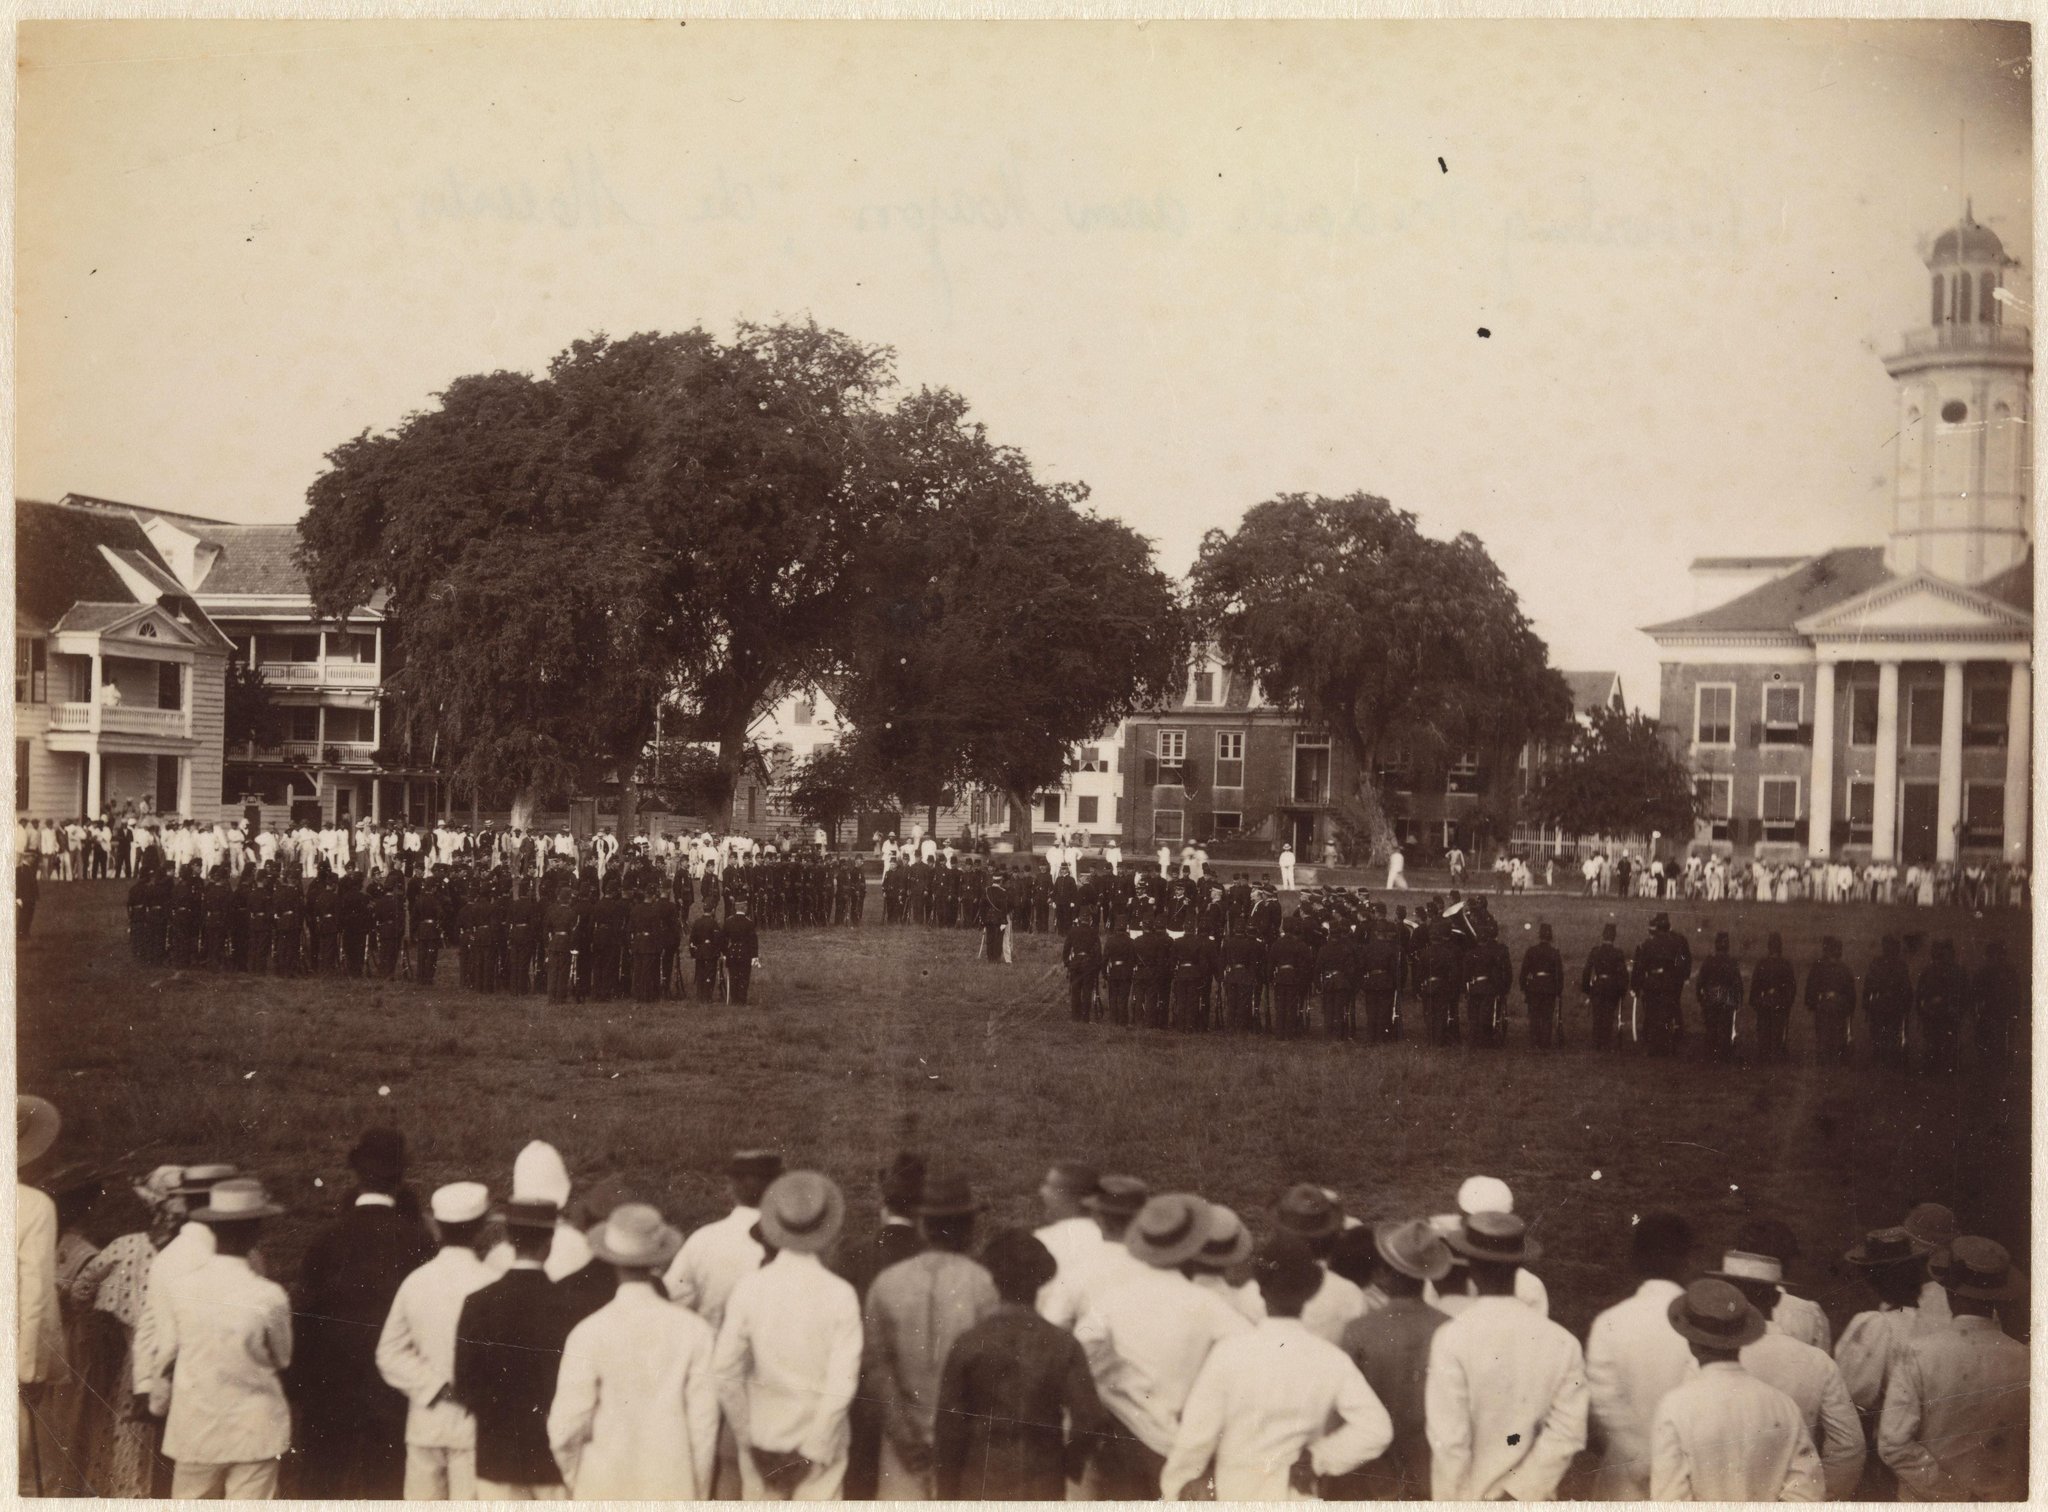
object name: photograph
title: Uitreiking medaille aan Majoor ‘de Meester’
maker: julius muller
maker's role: official, politician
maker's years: 1846-1902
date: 1882-1902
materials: photographic support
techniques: albumen print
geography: suriname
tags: medals and other marks of military honour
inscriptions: inscription: ‘Uitreiking medaille aan Majoor ‘de Meester’’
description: Parade bij de uitreiking van de onderscheiding tot ridder in de orde van de Nederlandse Leeuw aan majoor J.F. de Meester (1854-1936) op het gouvernementsplein in Paramaribo.